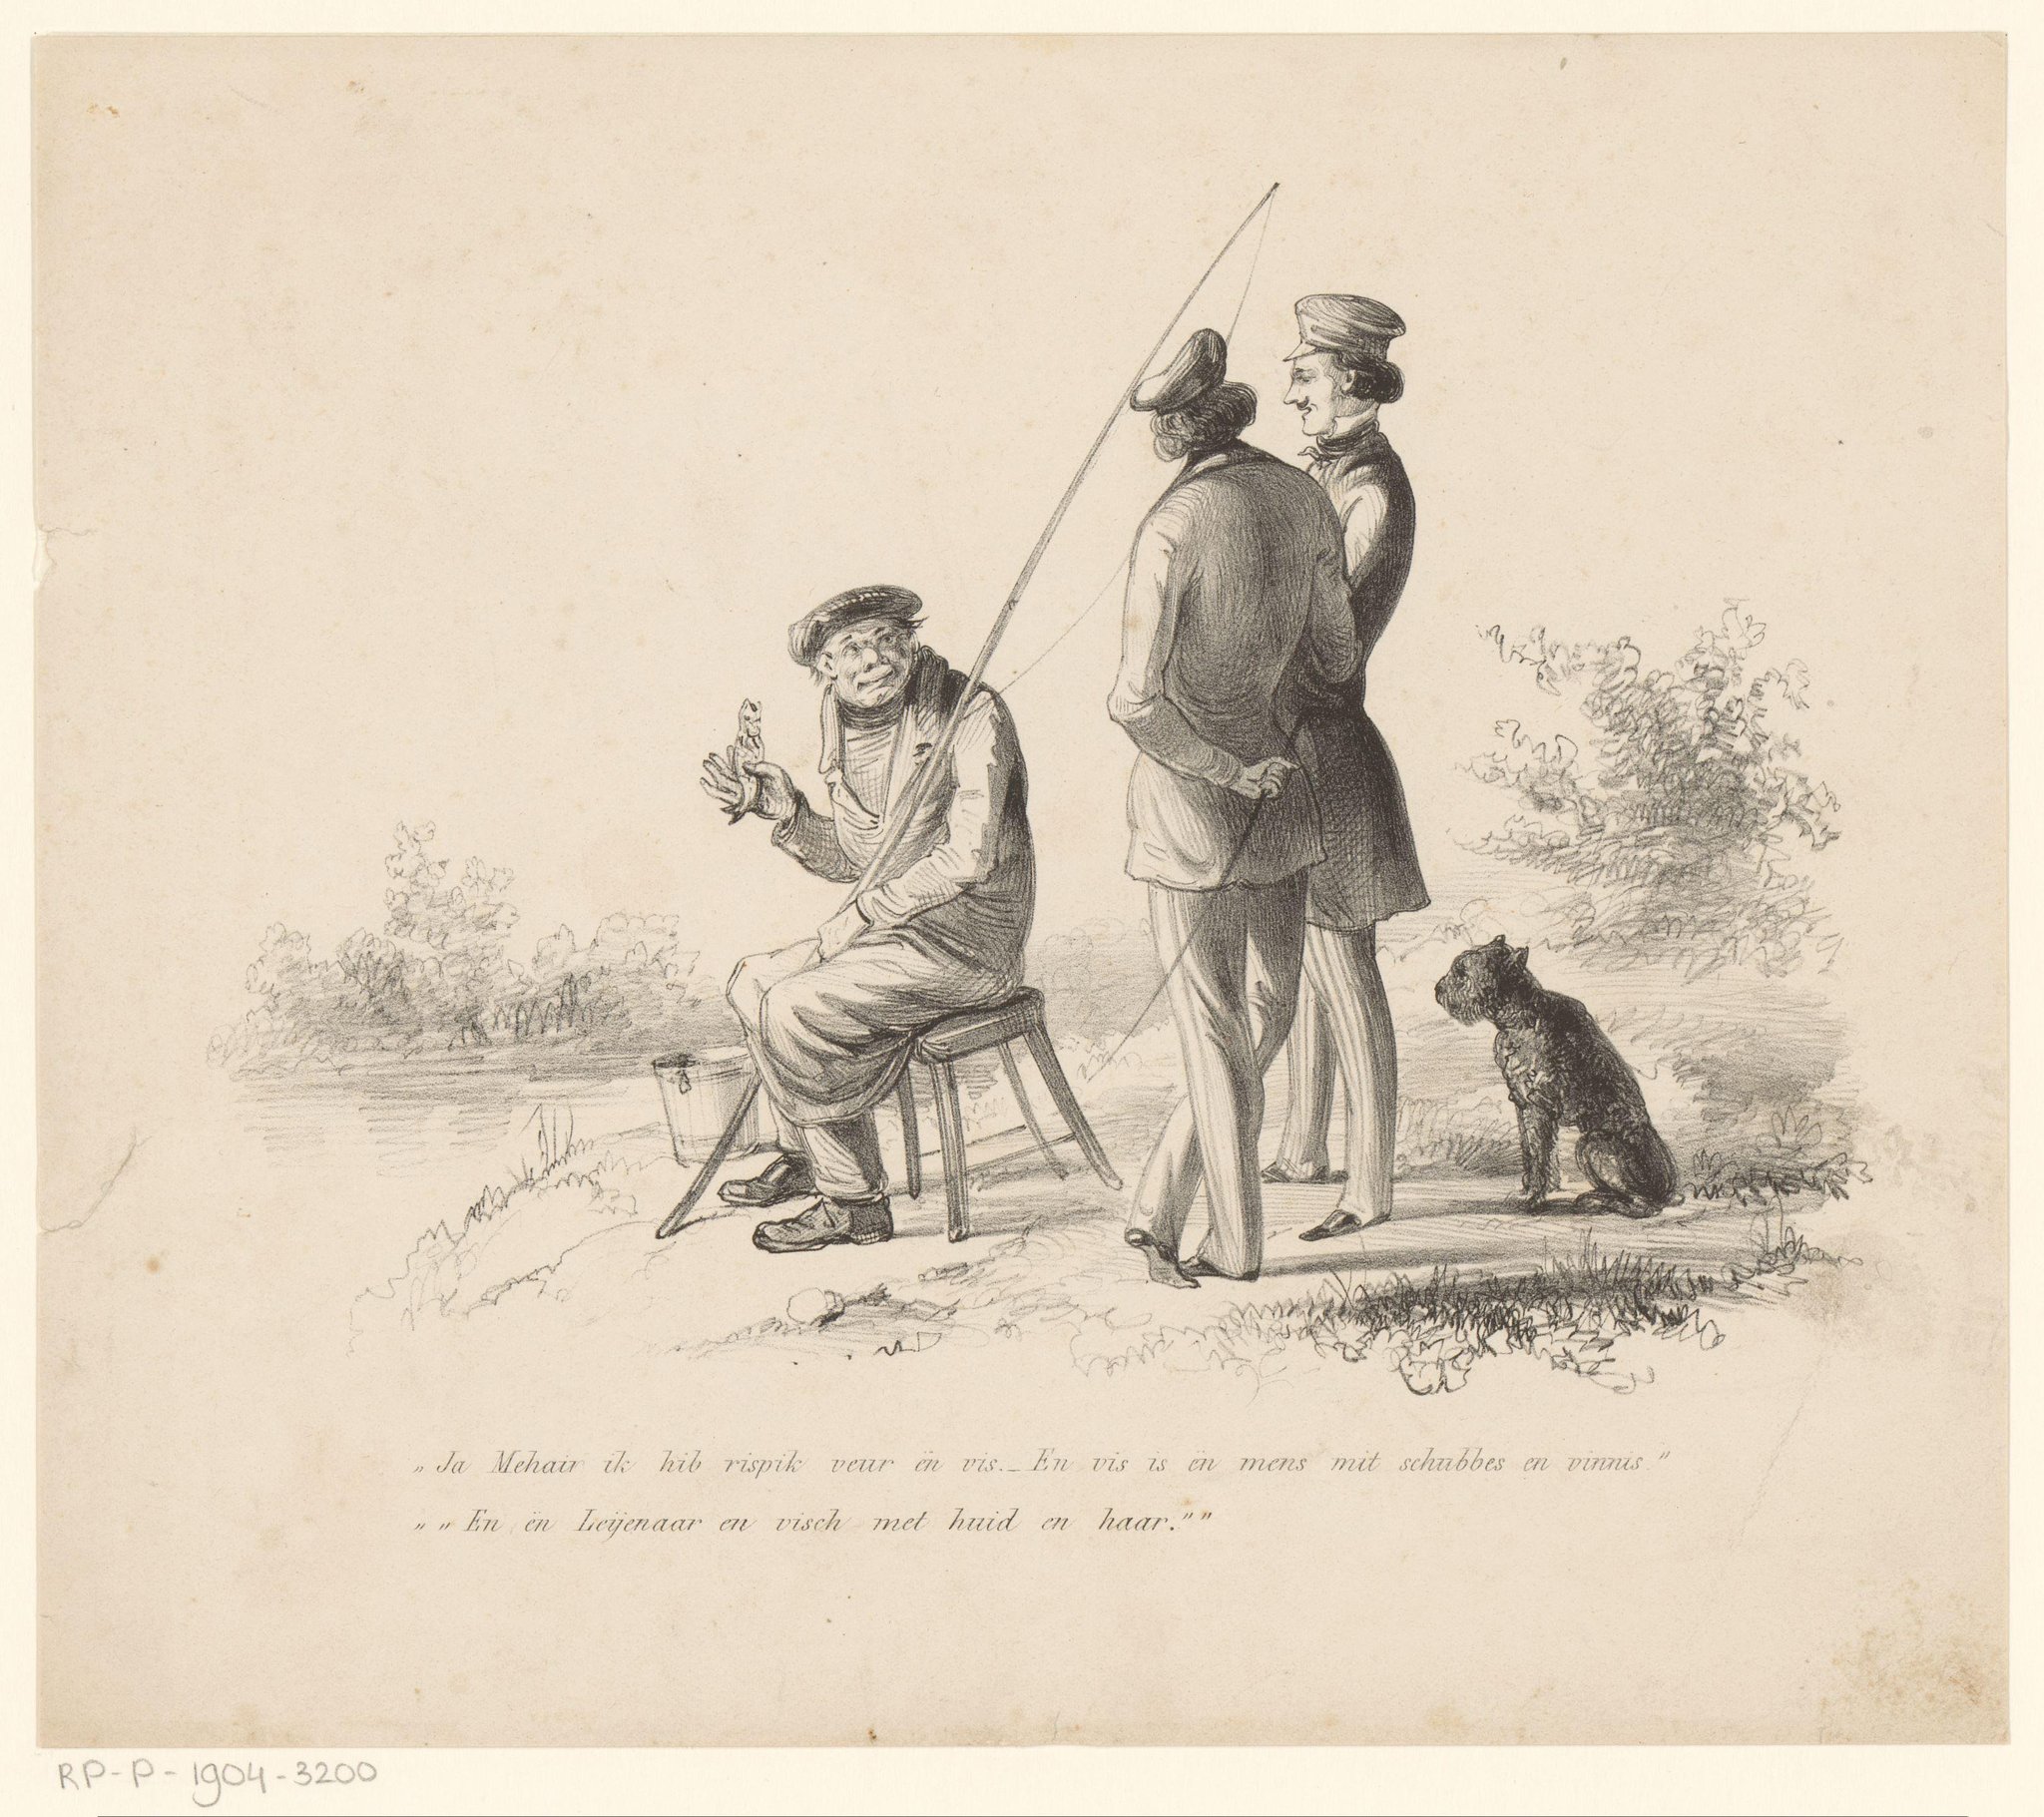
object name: print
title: Visser in gesprek met twee mannen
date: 1832-1897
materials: paper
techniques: lithograph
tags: fishing (sports), conversation, dialogue; conversation piece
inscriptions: collector's mark: Lugt 2228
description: Een oude visser met een vis in zijn hand is in gesprek met twee jongemannen.